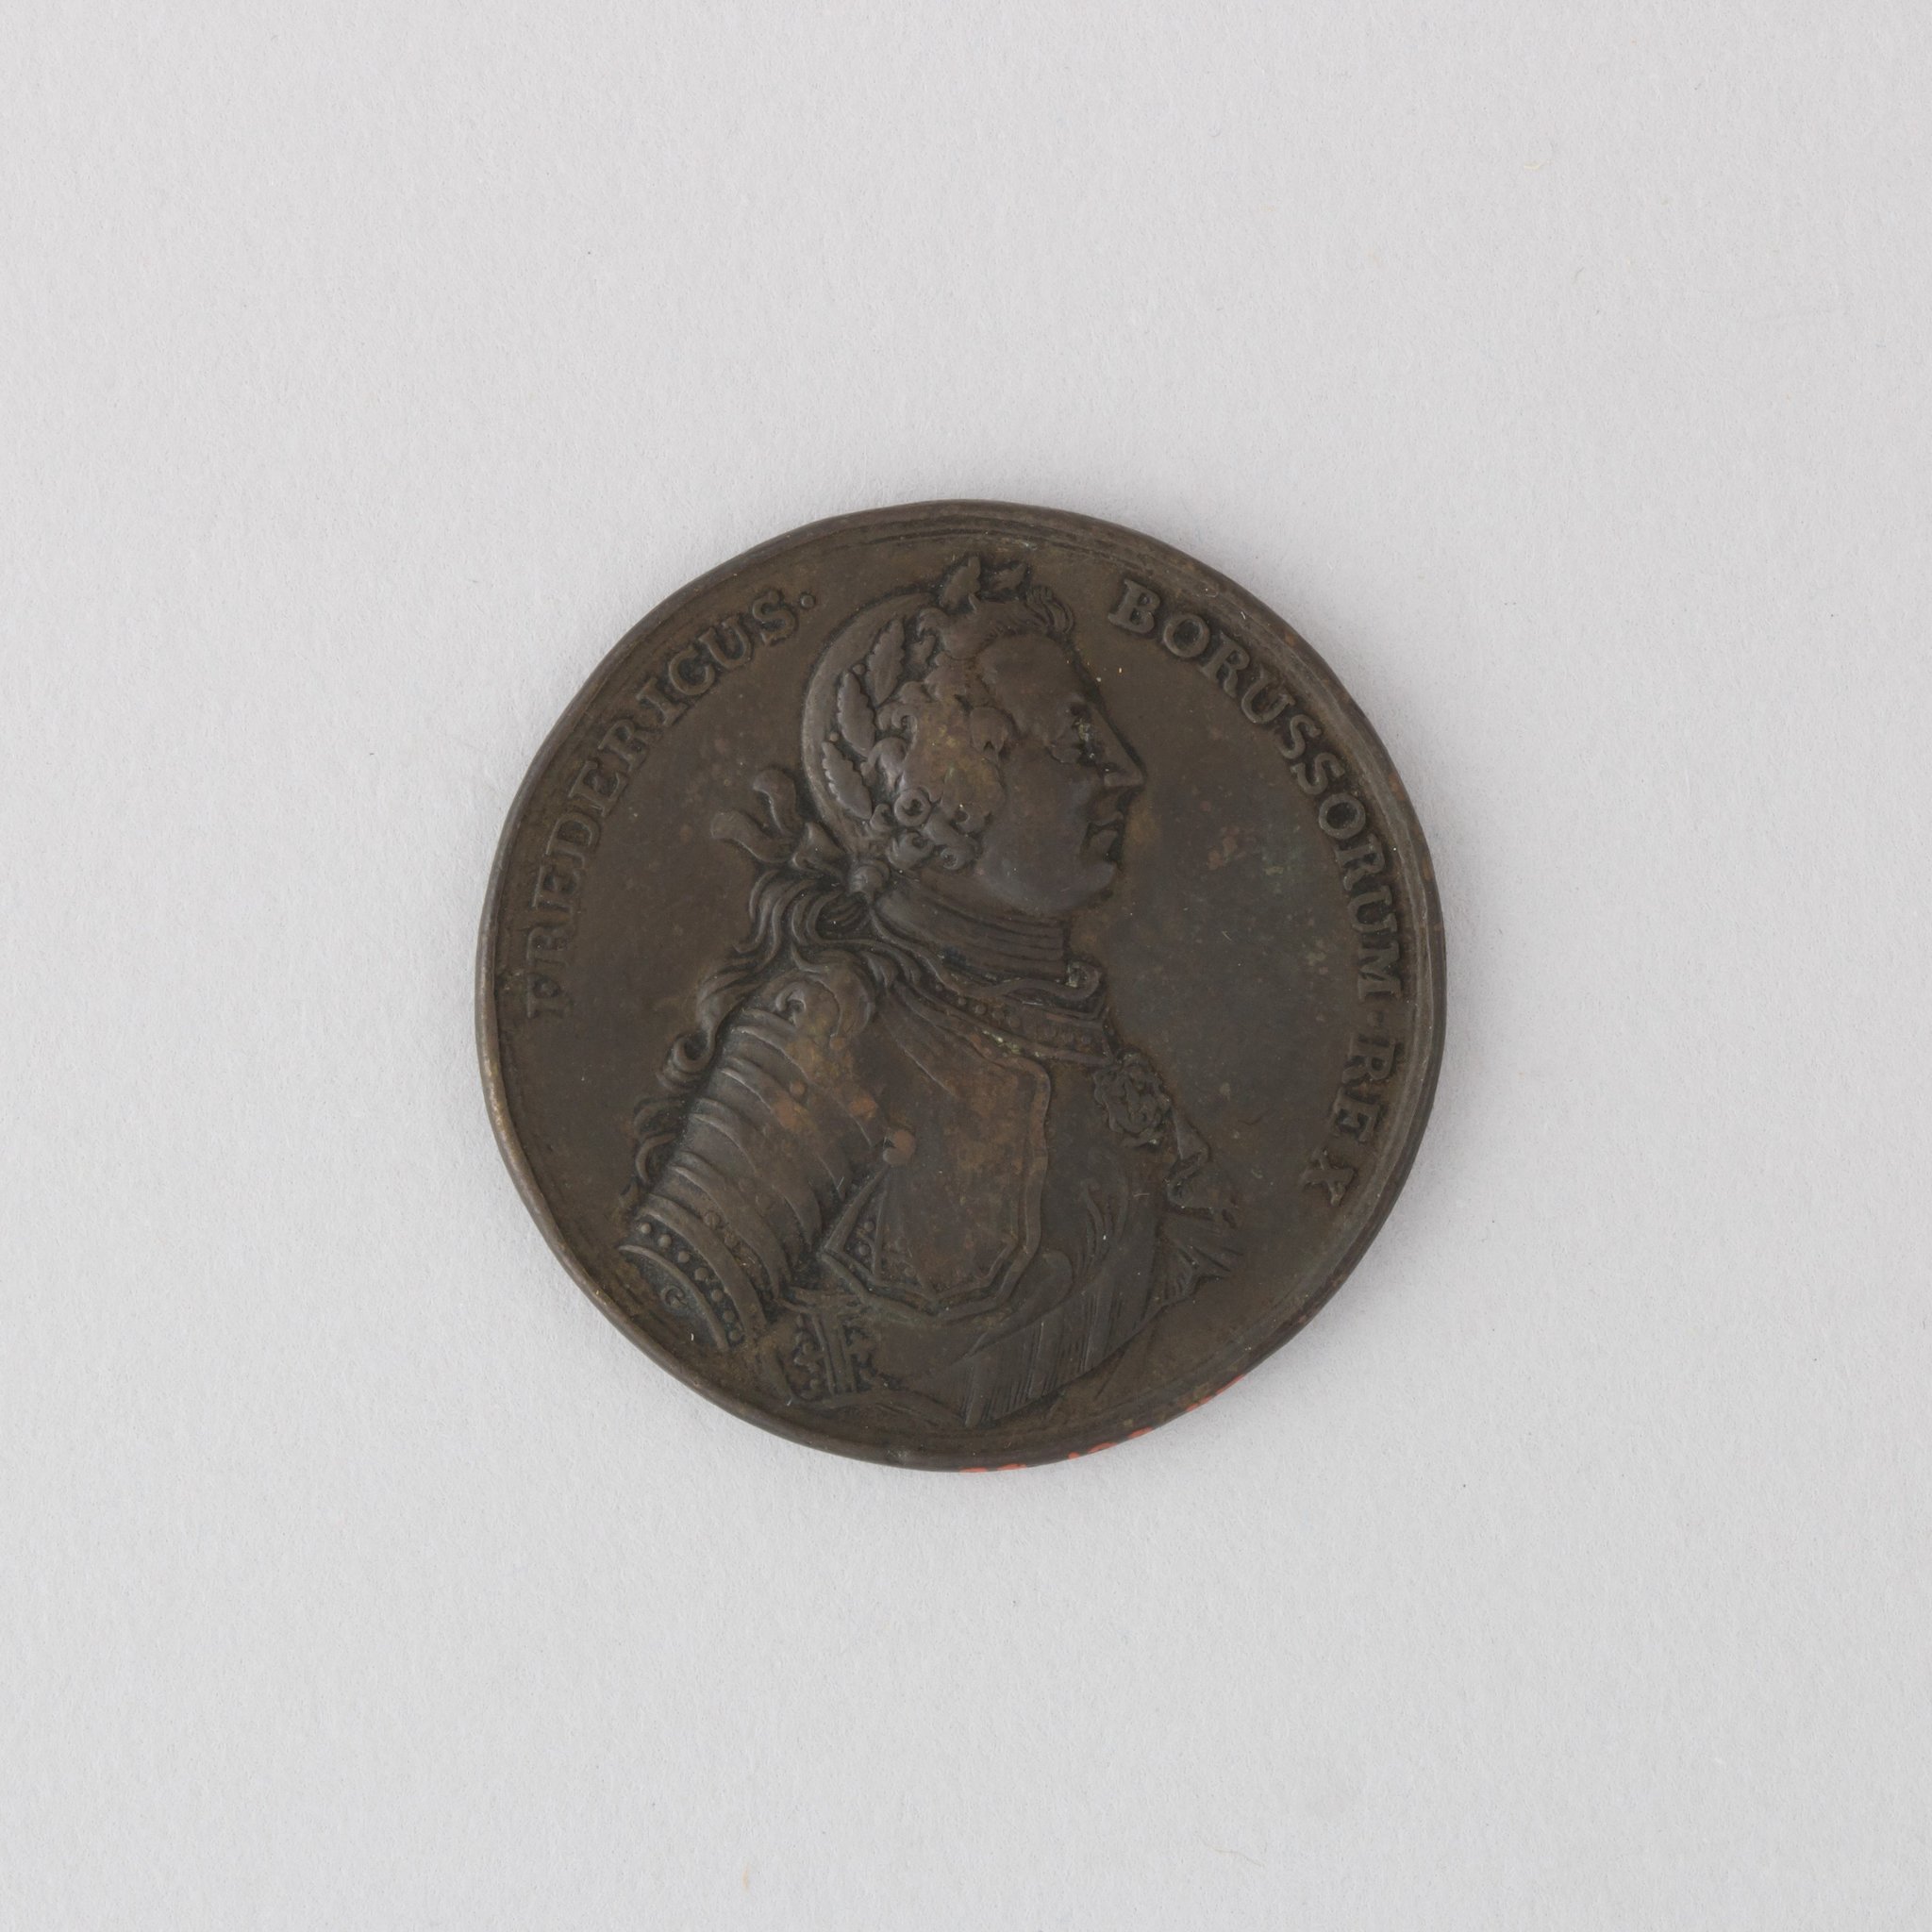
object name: medal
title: Medal Showing Frederick the Great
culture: german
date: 1758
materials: bronze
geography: germany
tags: men,profiles